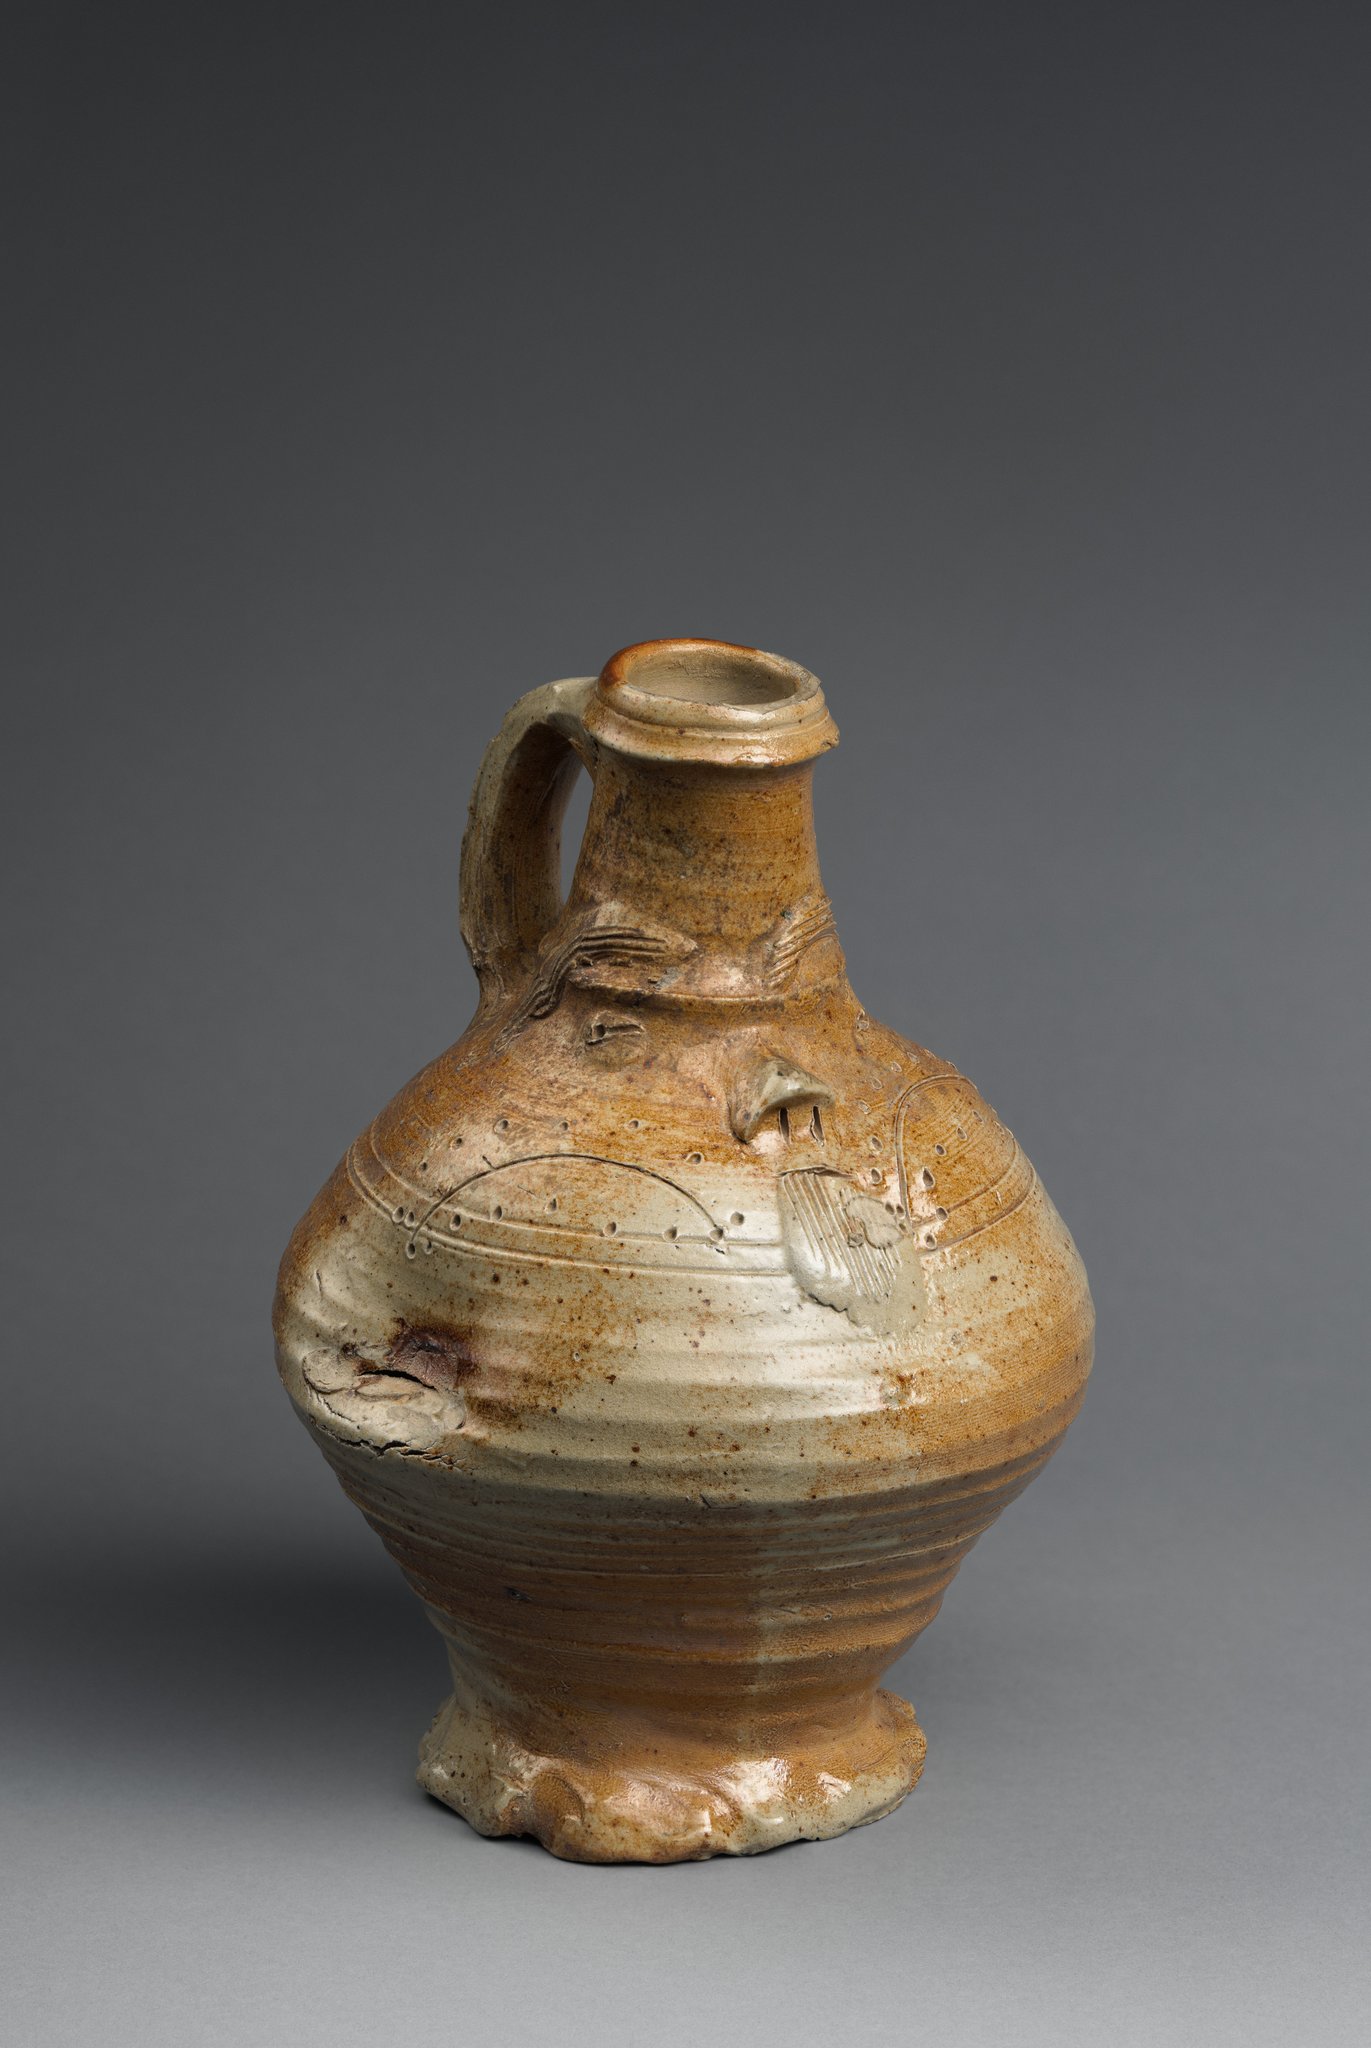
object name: jug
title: Face jug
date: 1500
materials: stoneware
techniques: salt glaze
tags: faces